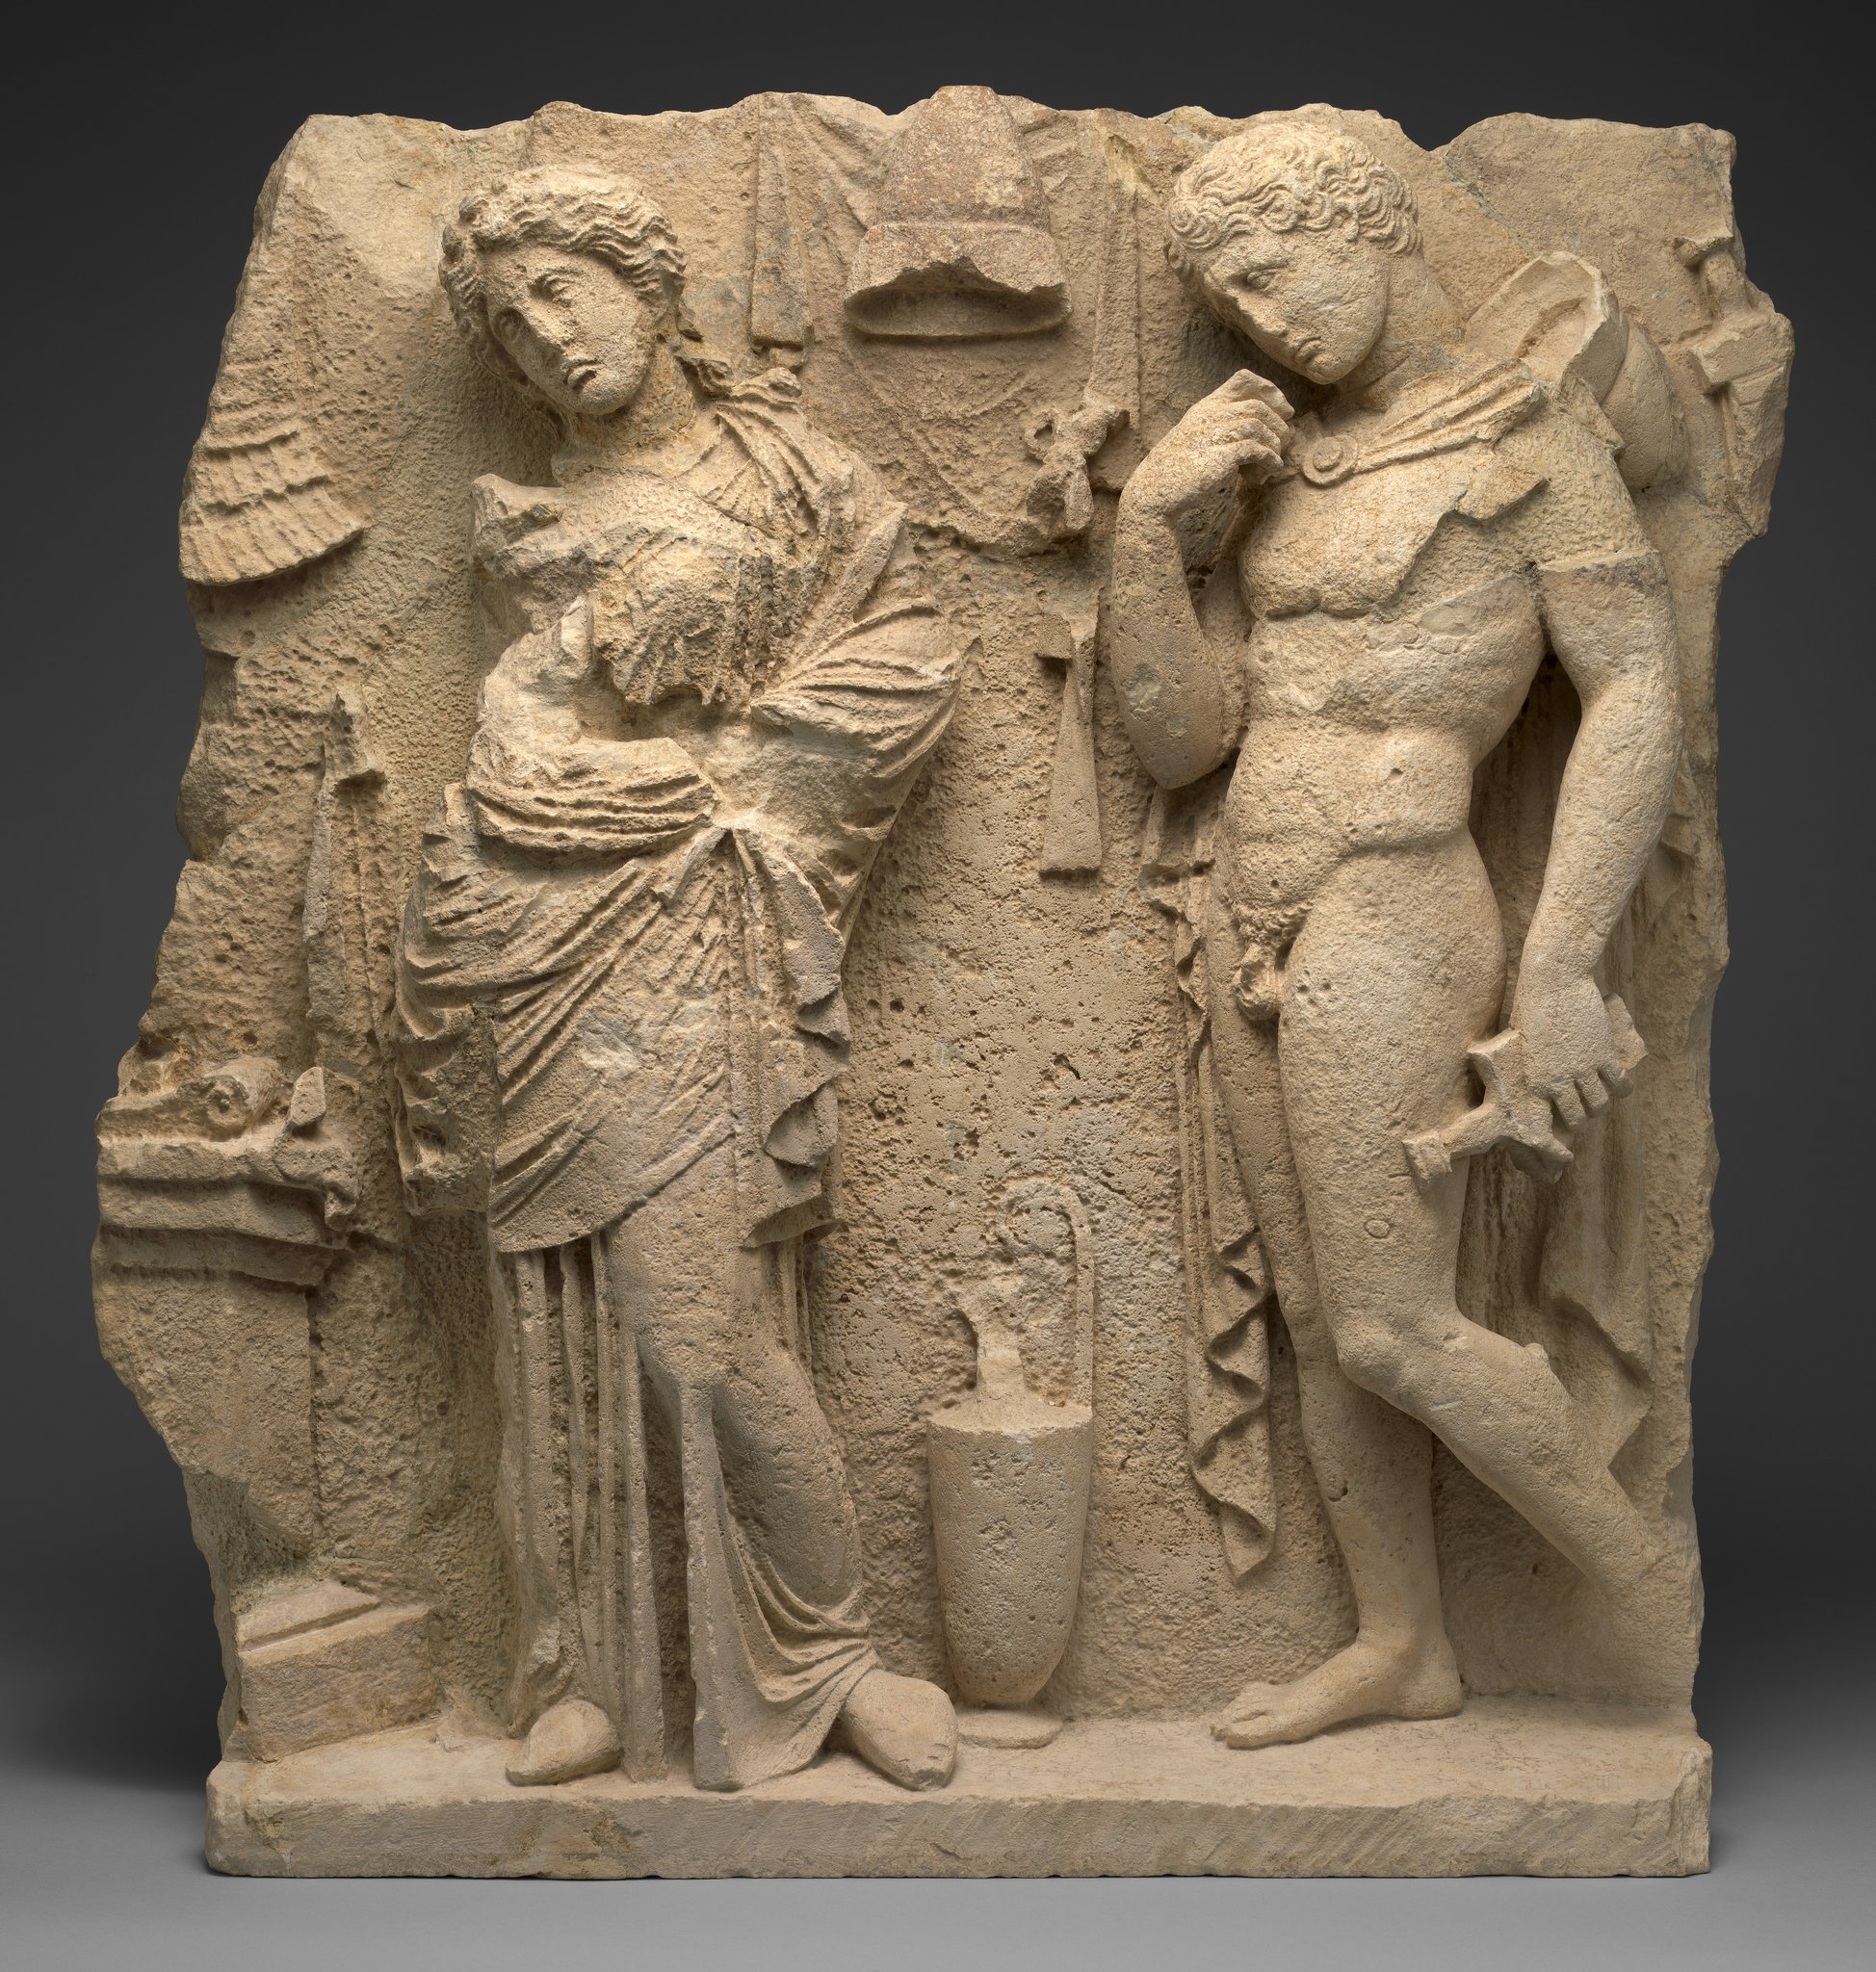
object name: relief fragment from a funerary monument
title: Limestone funerary relief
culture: greek, south italian, tarentine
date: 325-300 BCE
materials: limestone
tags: male nudes,women